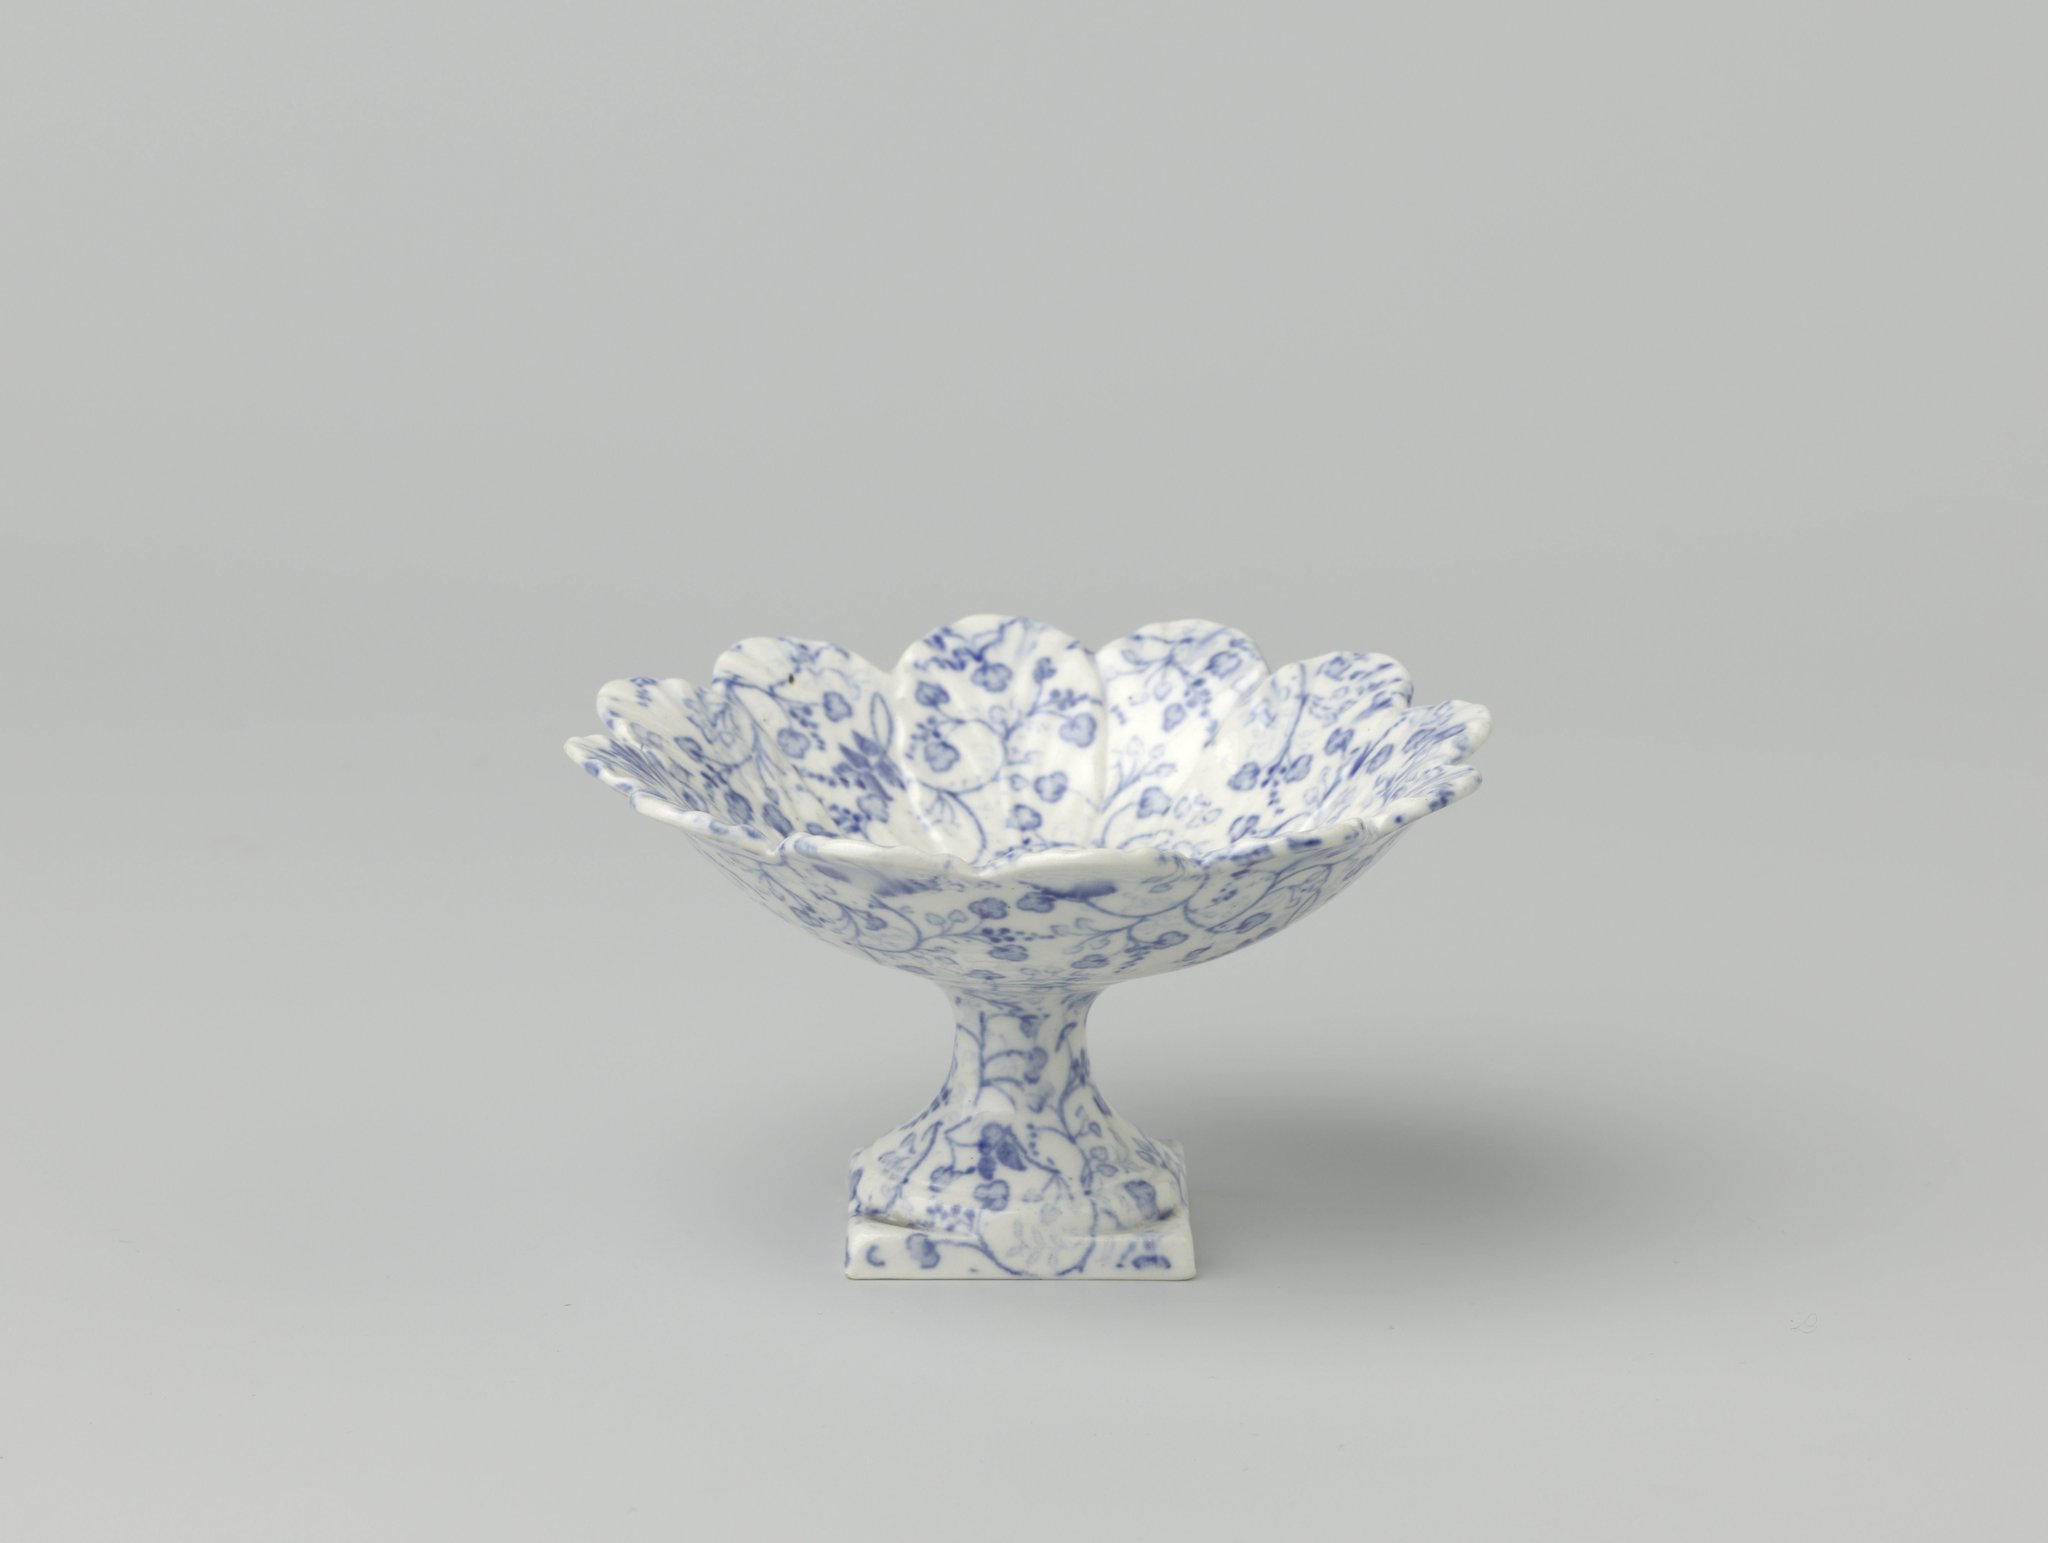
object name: dish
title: Fruitschaal op voet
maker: petrus regout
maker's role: plateelbakker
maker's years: 1801-1879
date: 1867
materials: creamware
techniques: transfer decoration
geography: maastricht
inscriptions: mark: ‘2 67’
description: Fruitschaal op voet van aardewerk met blauw doorlopend bloemendecor, behorend tot een kinderservies. De schaal heeft de vorm van een geopende bloem. De ronde stam staat op een vierkante plint.